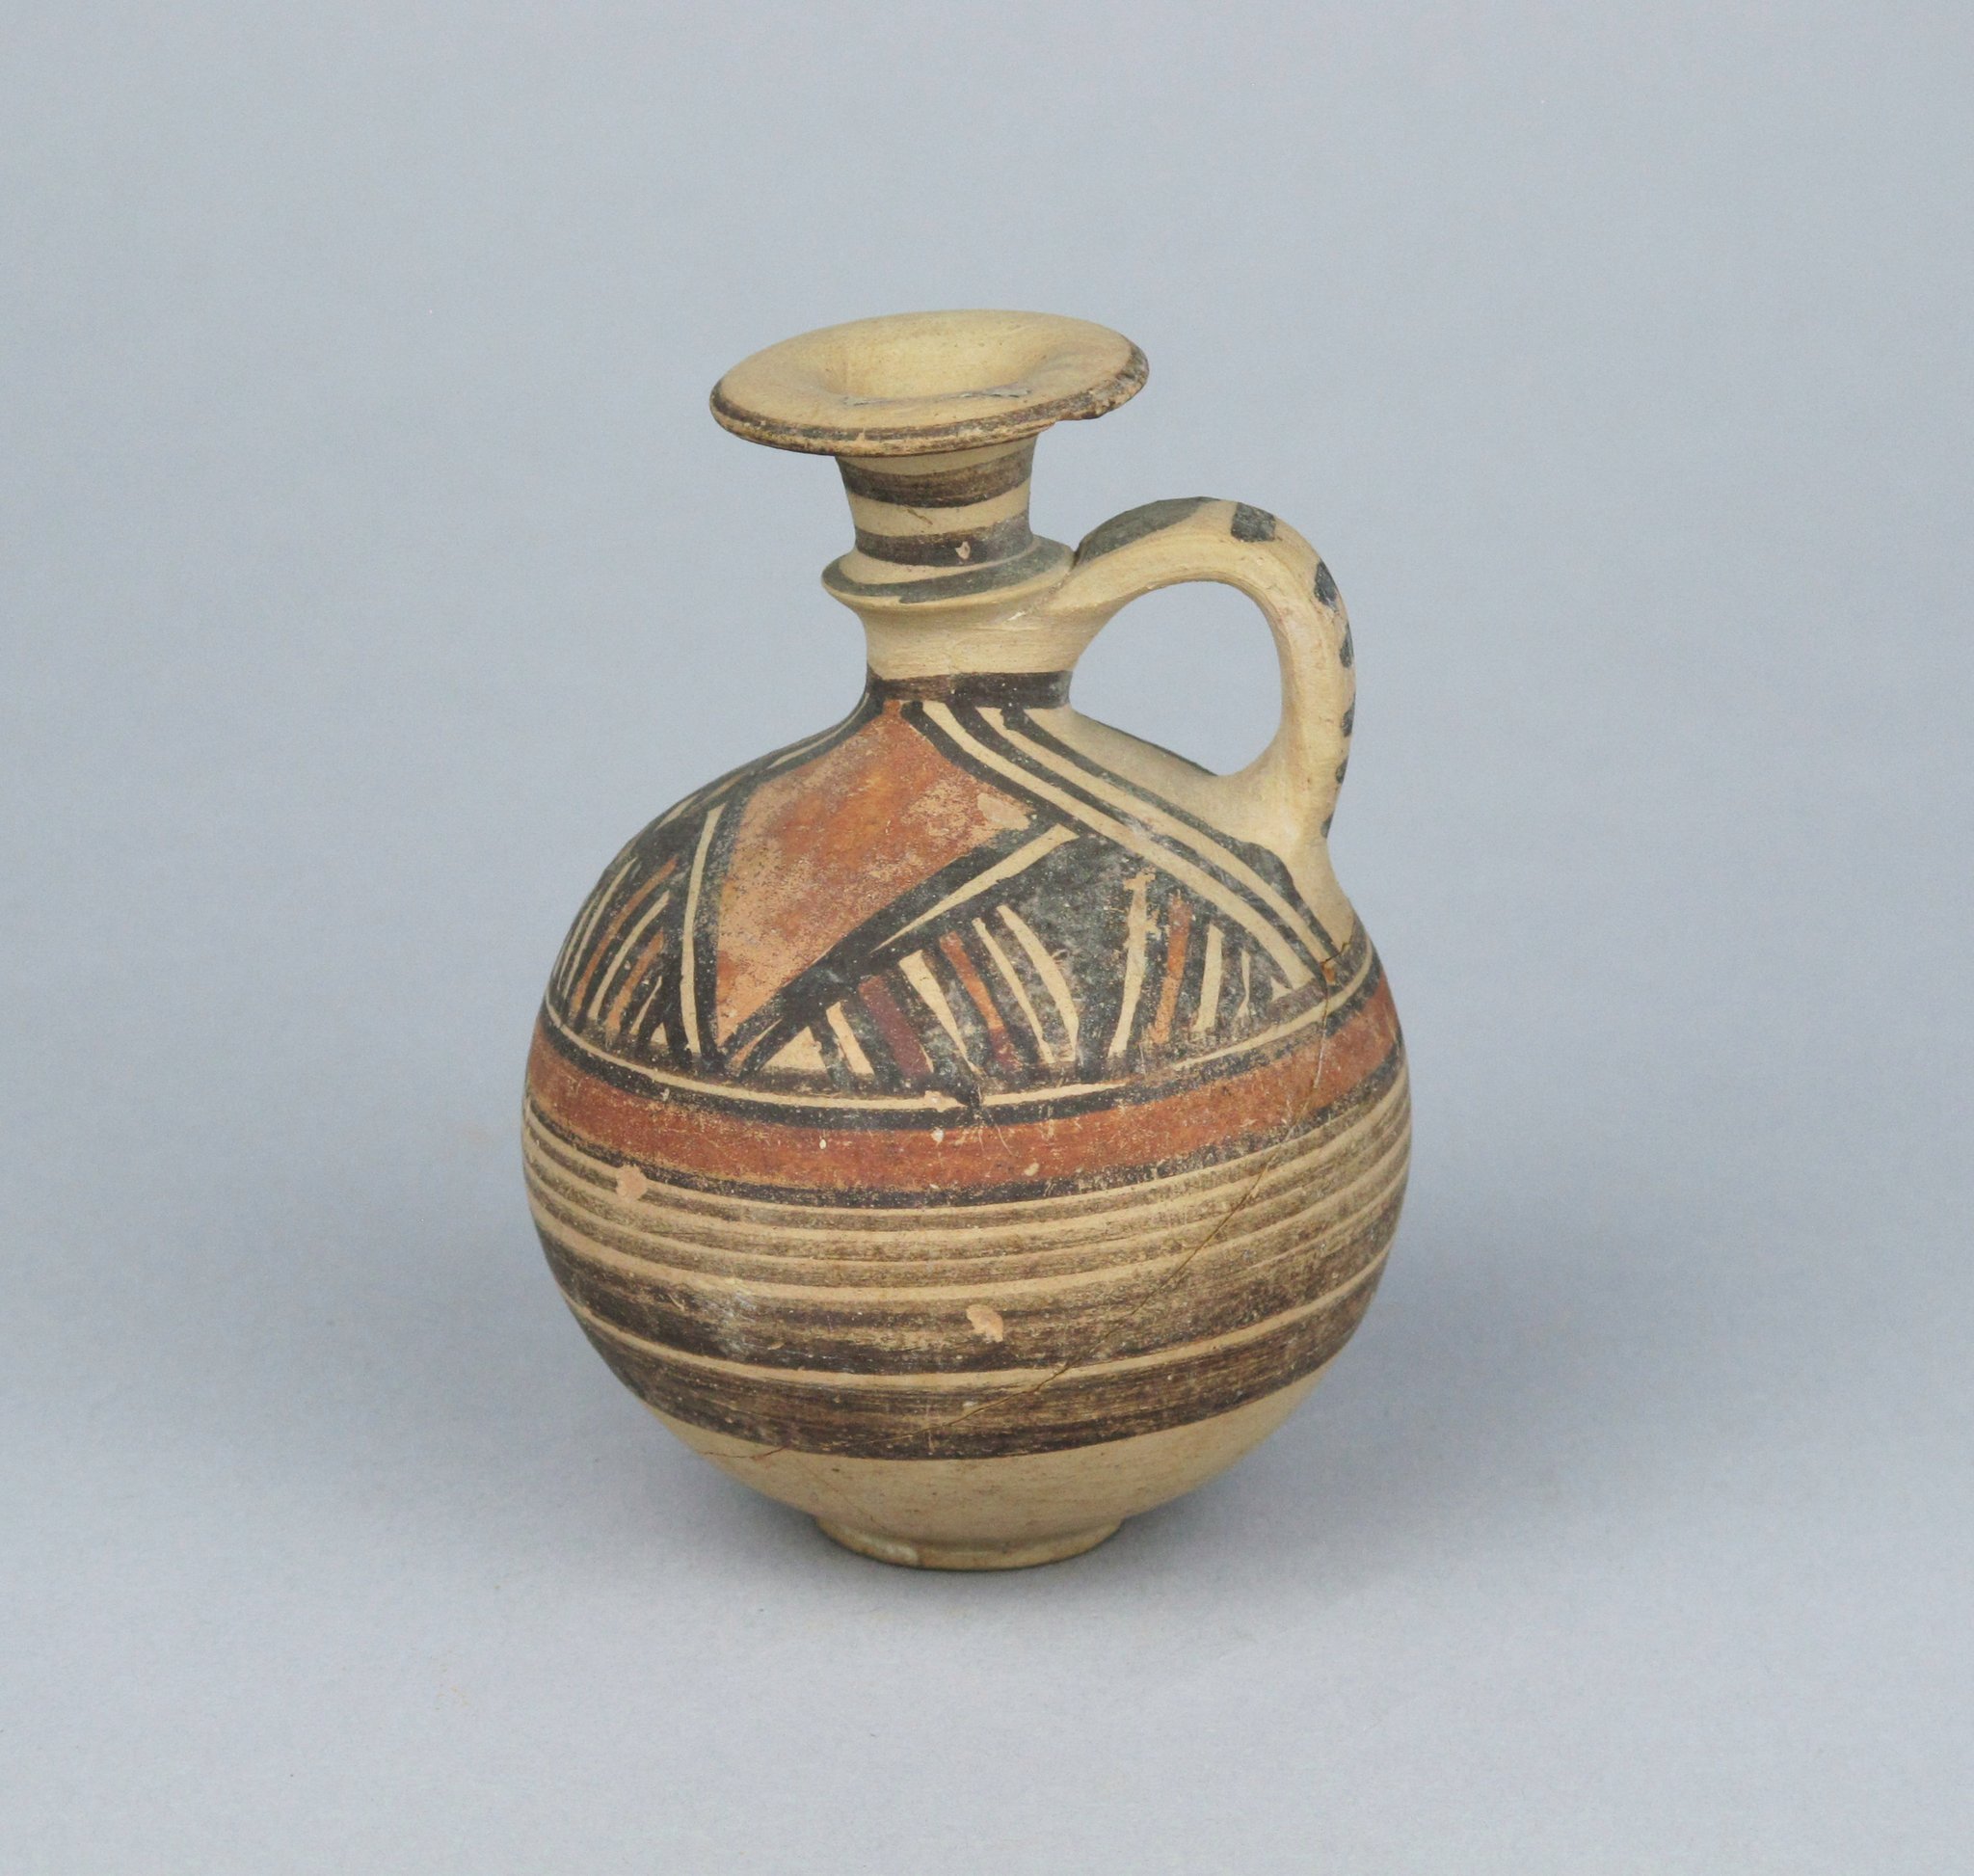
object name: juglet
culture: cypriot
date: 750-480 BCE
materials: terracotta